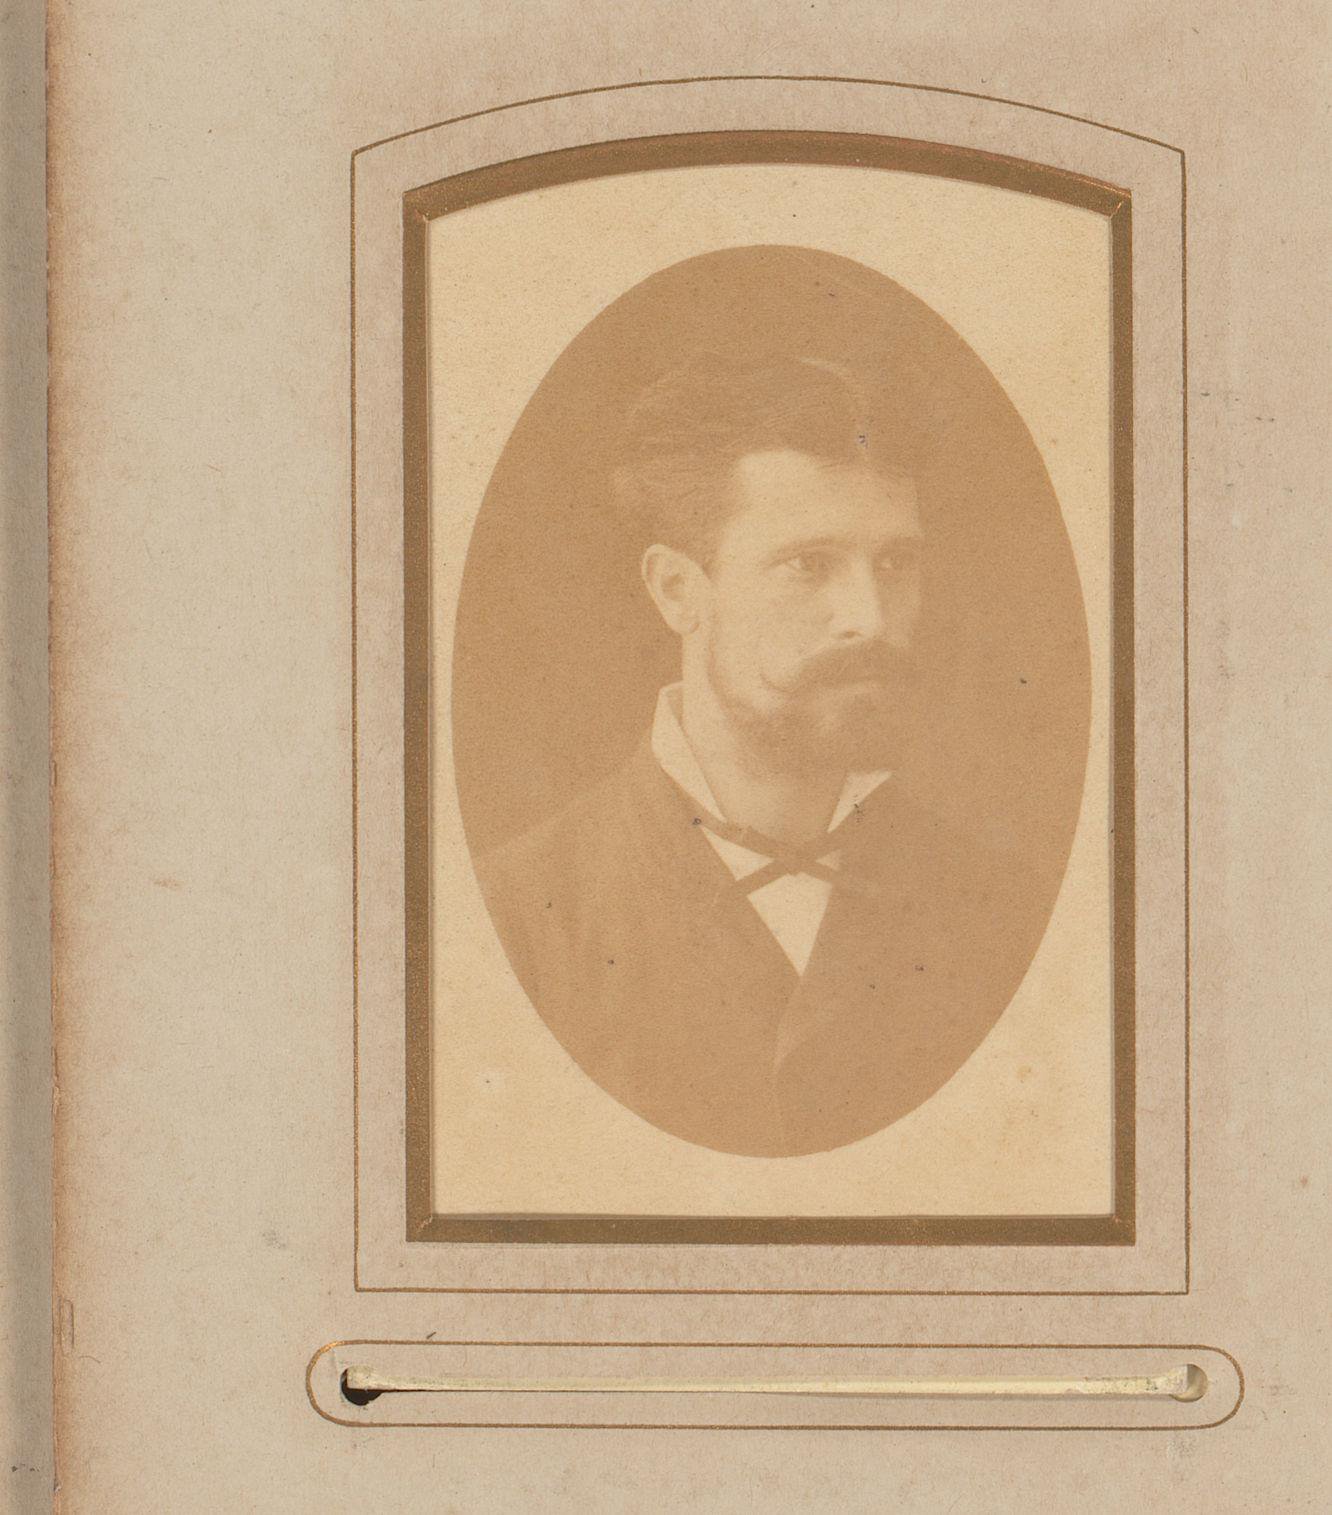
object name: photograph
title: Portret van een man met snor en baard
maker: Anonymous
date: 1860-1900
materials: cardboard, photographic support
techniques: albumen print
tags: moustache, historical persons, beard